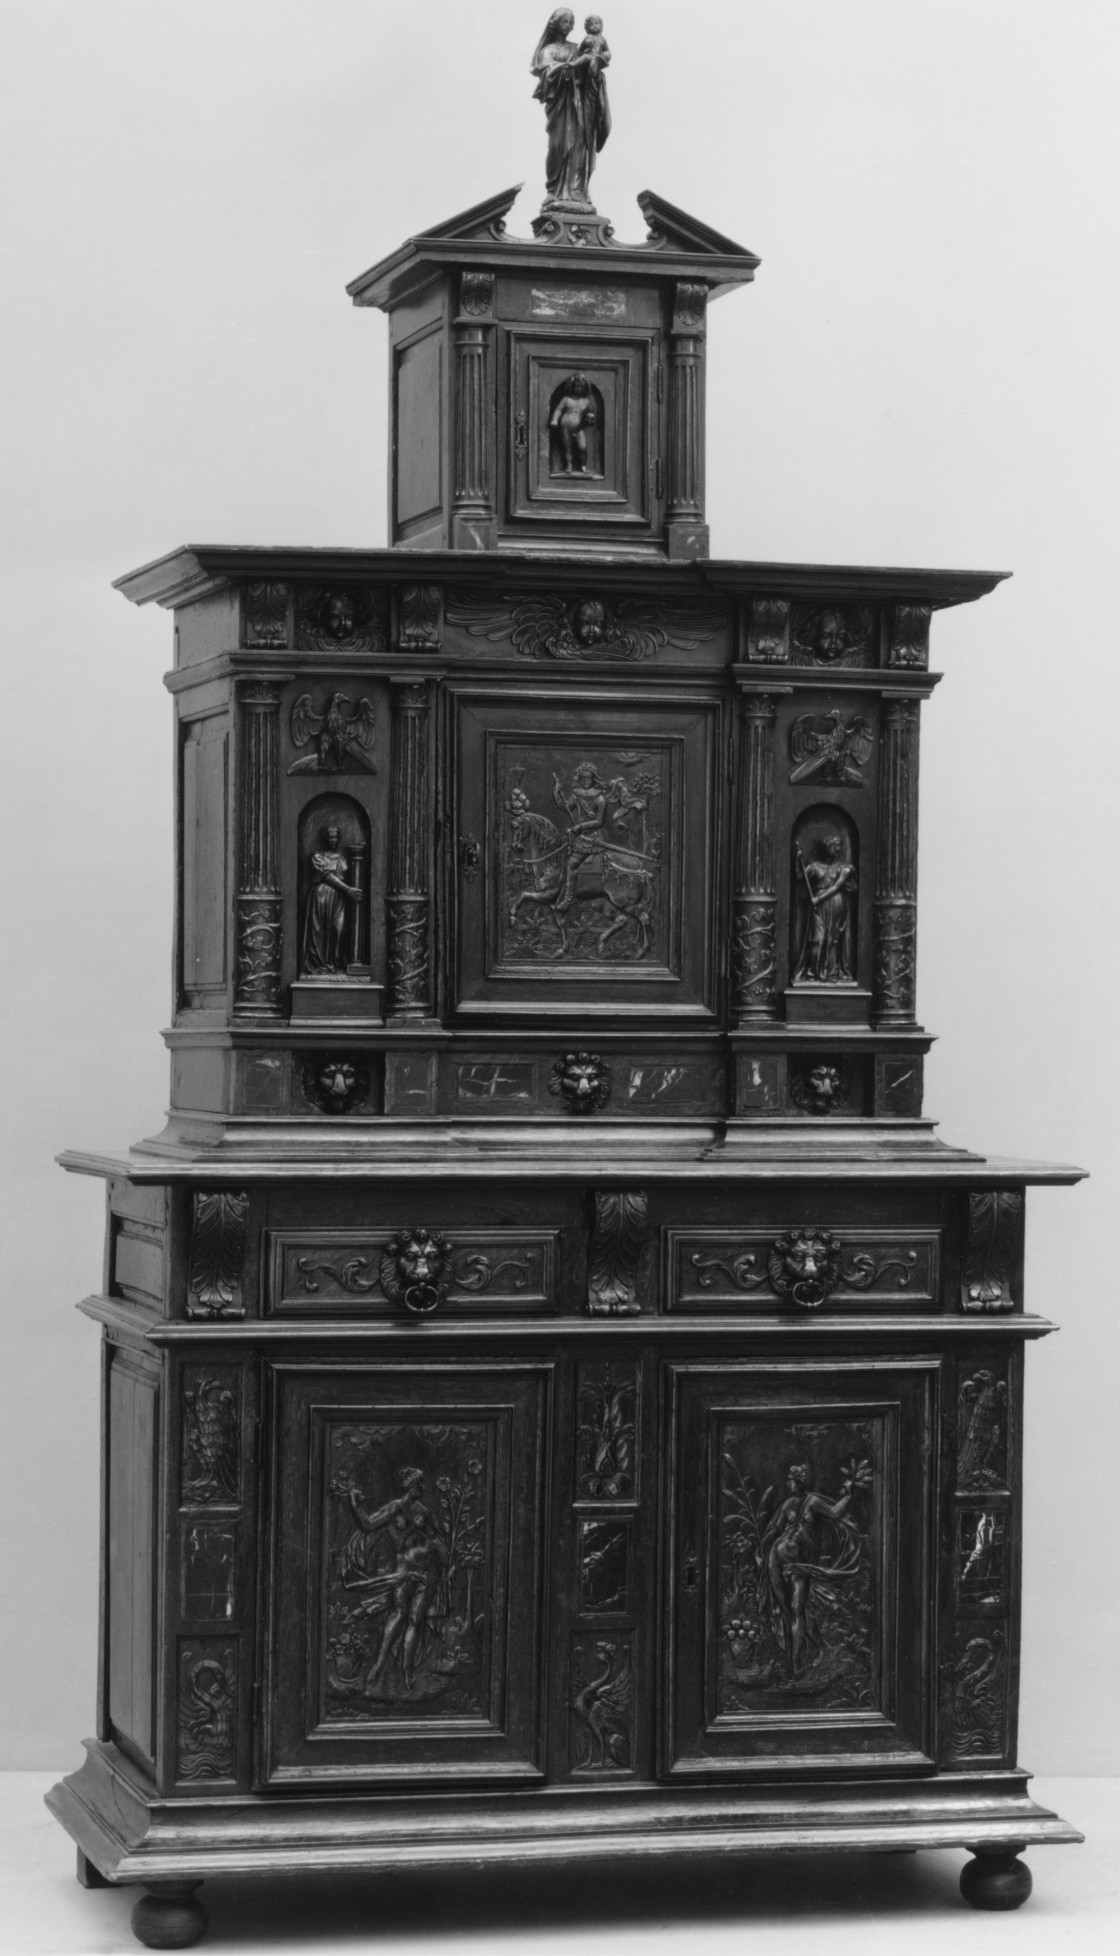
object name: cabinet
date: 1601-1650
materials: wood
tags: horses,lions,madonna and child